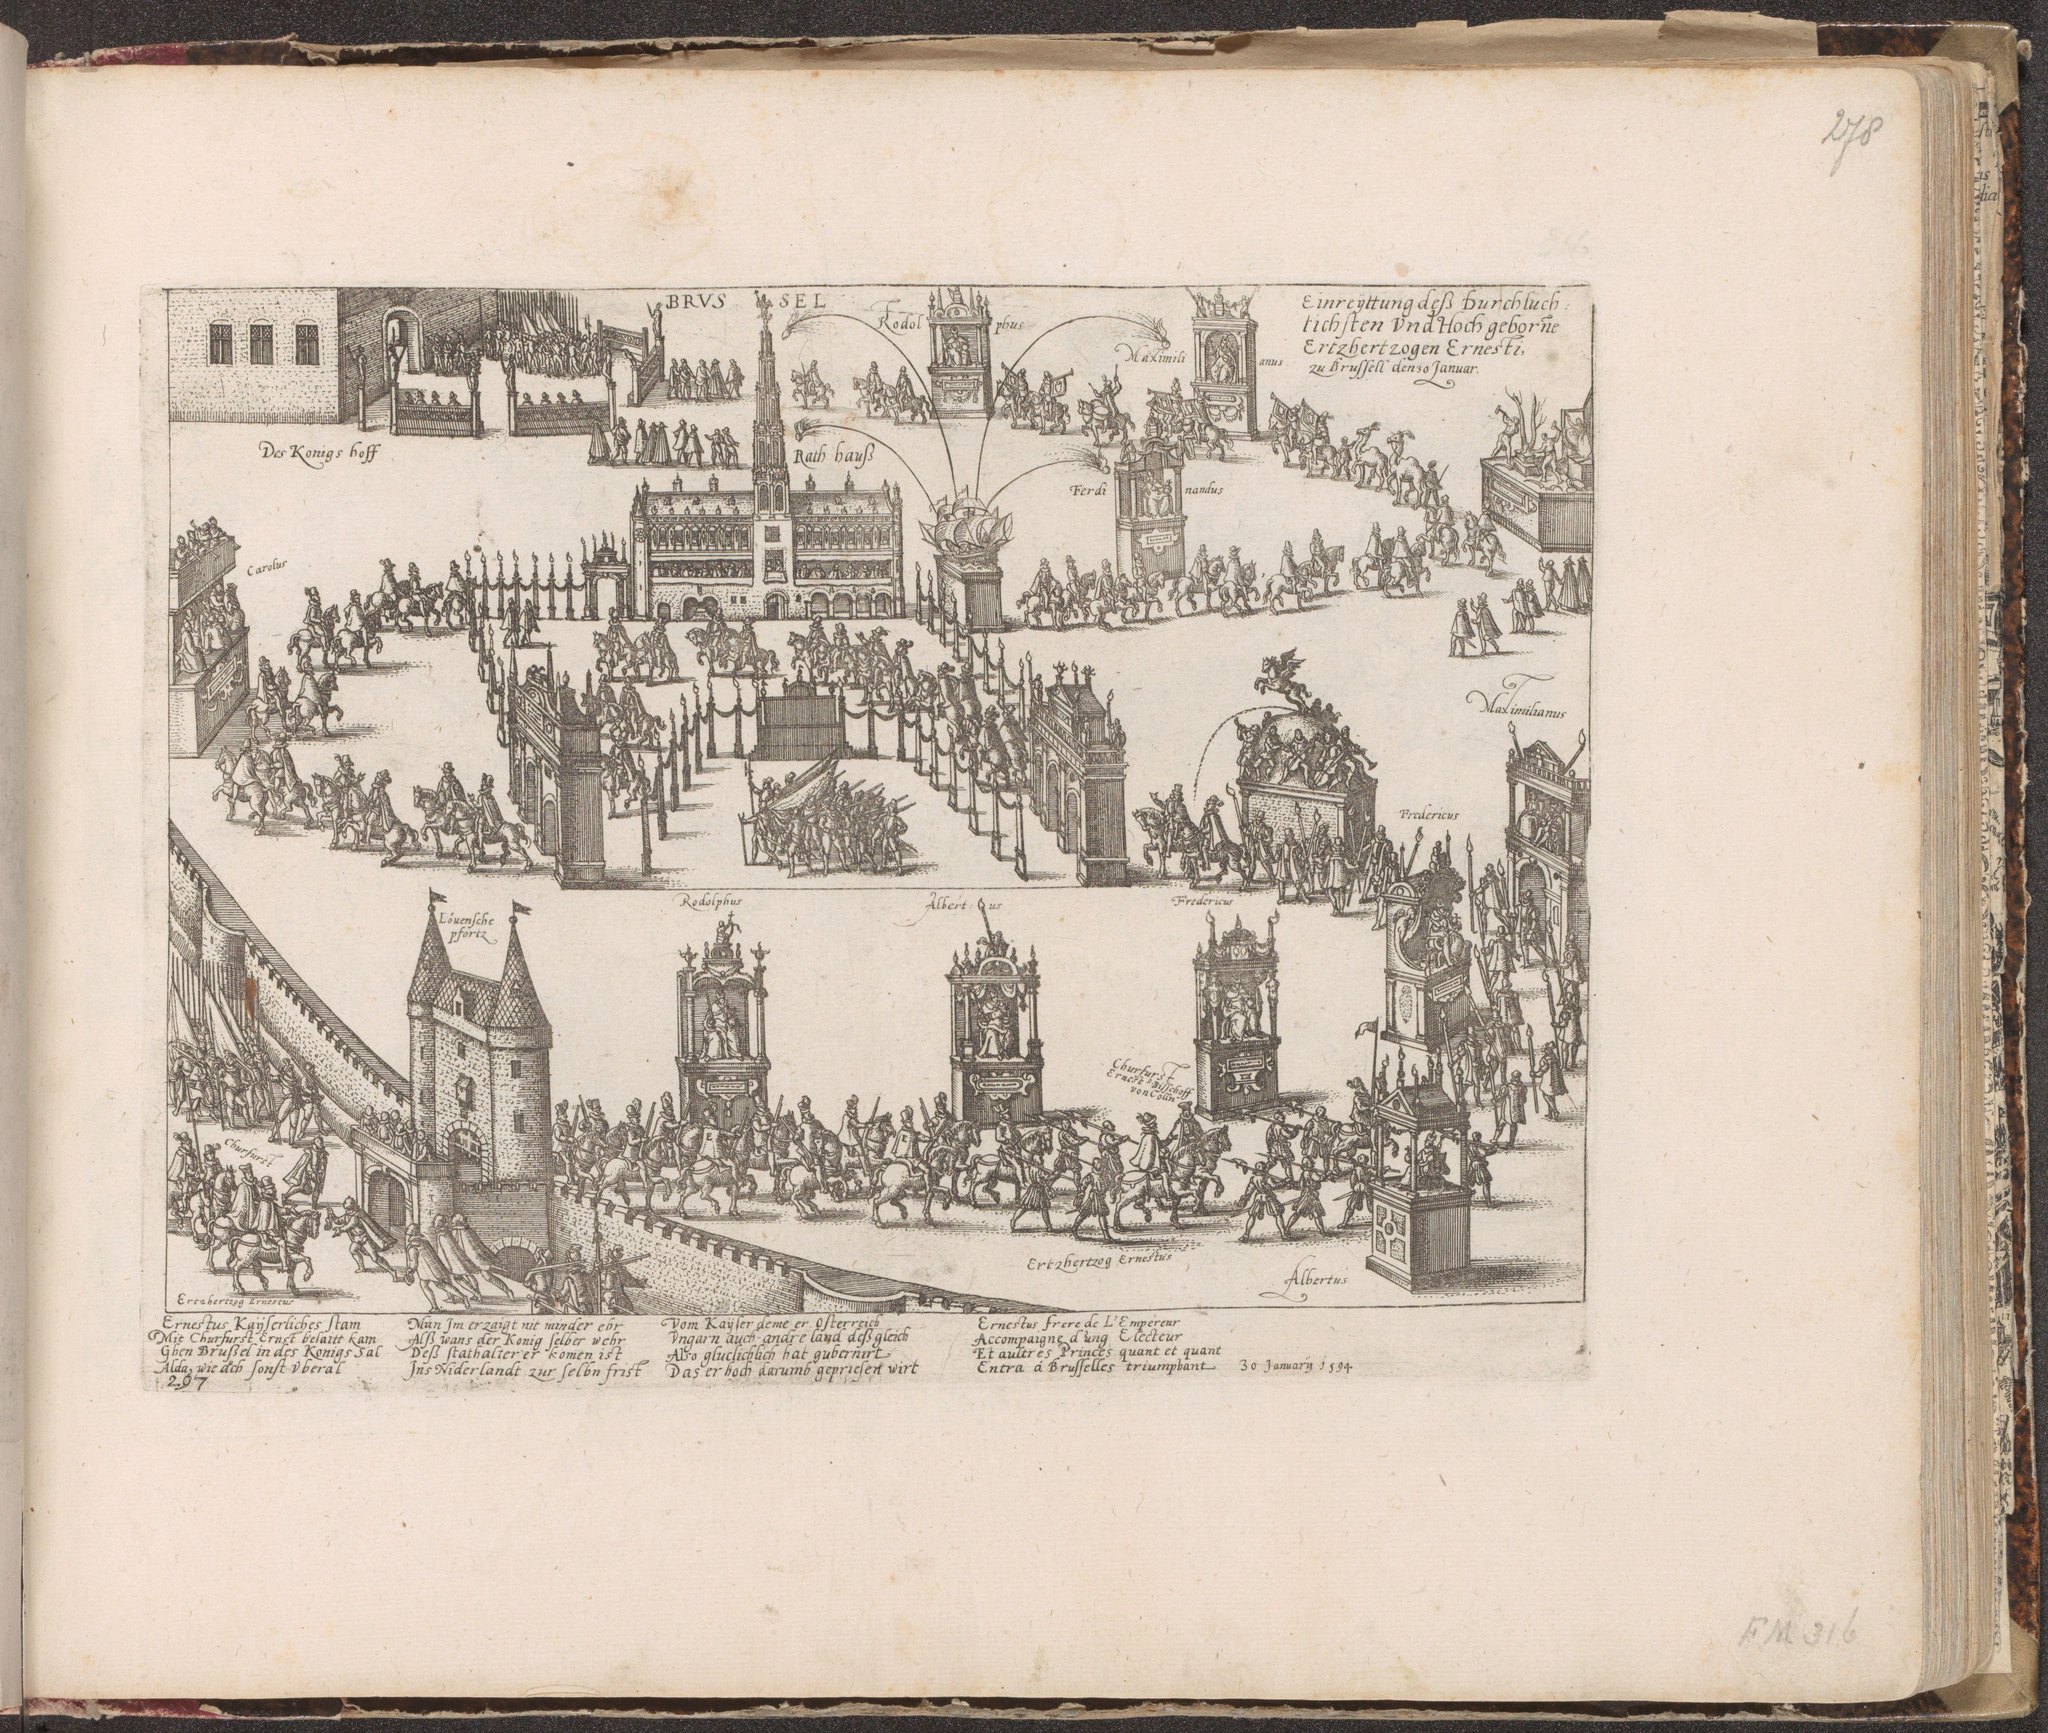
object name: history print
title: Serie 10: Nederlandse en Buitenlandse Gebeurtenissen, 1587-1612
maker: frans hogenberg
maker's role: print maker, publisher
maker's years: 1538-1590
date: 1594-1596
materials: paper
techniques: etching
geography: cologne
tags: vienna, brussels, triumphal entry and public reception, pageant, 'entrée solennelle', 'joyeuse entrée'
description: Feestelijke intocht van aartshertog Ernst van Oostenrijk te Brussel, 30 januari 1594. Linksonder arriveert Ernst bij de stadspoort, vervolgens rijdt de stoet langs standbeelden van Oostenrijkse keizers, triomfpoorten, het stadhuis naar het paleis linksboven. Met onderschrift van 12 regels in het Duits en 4 regels in het Frans. Linksonder genummerd: 297. De prent maakt deel uit van een album.